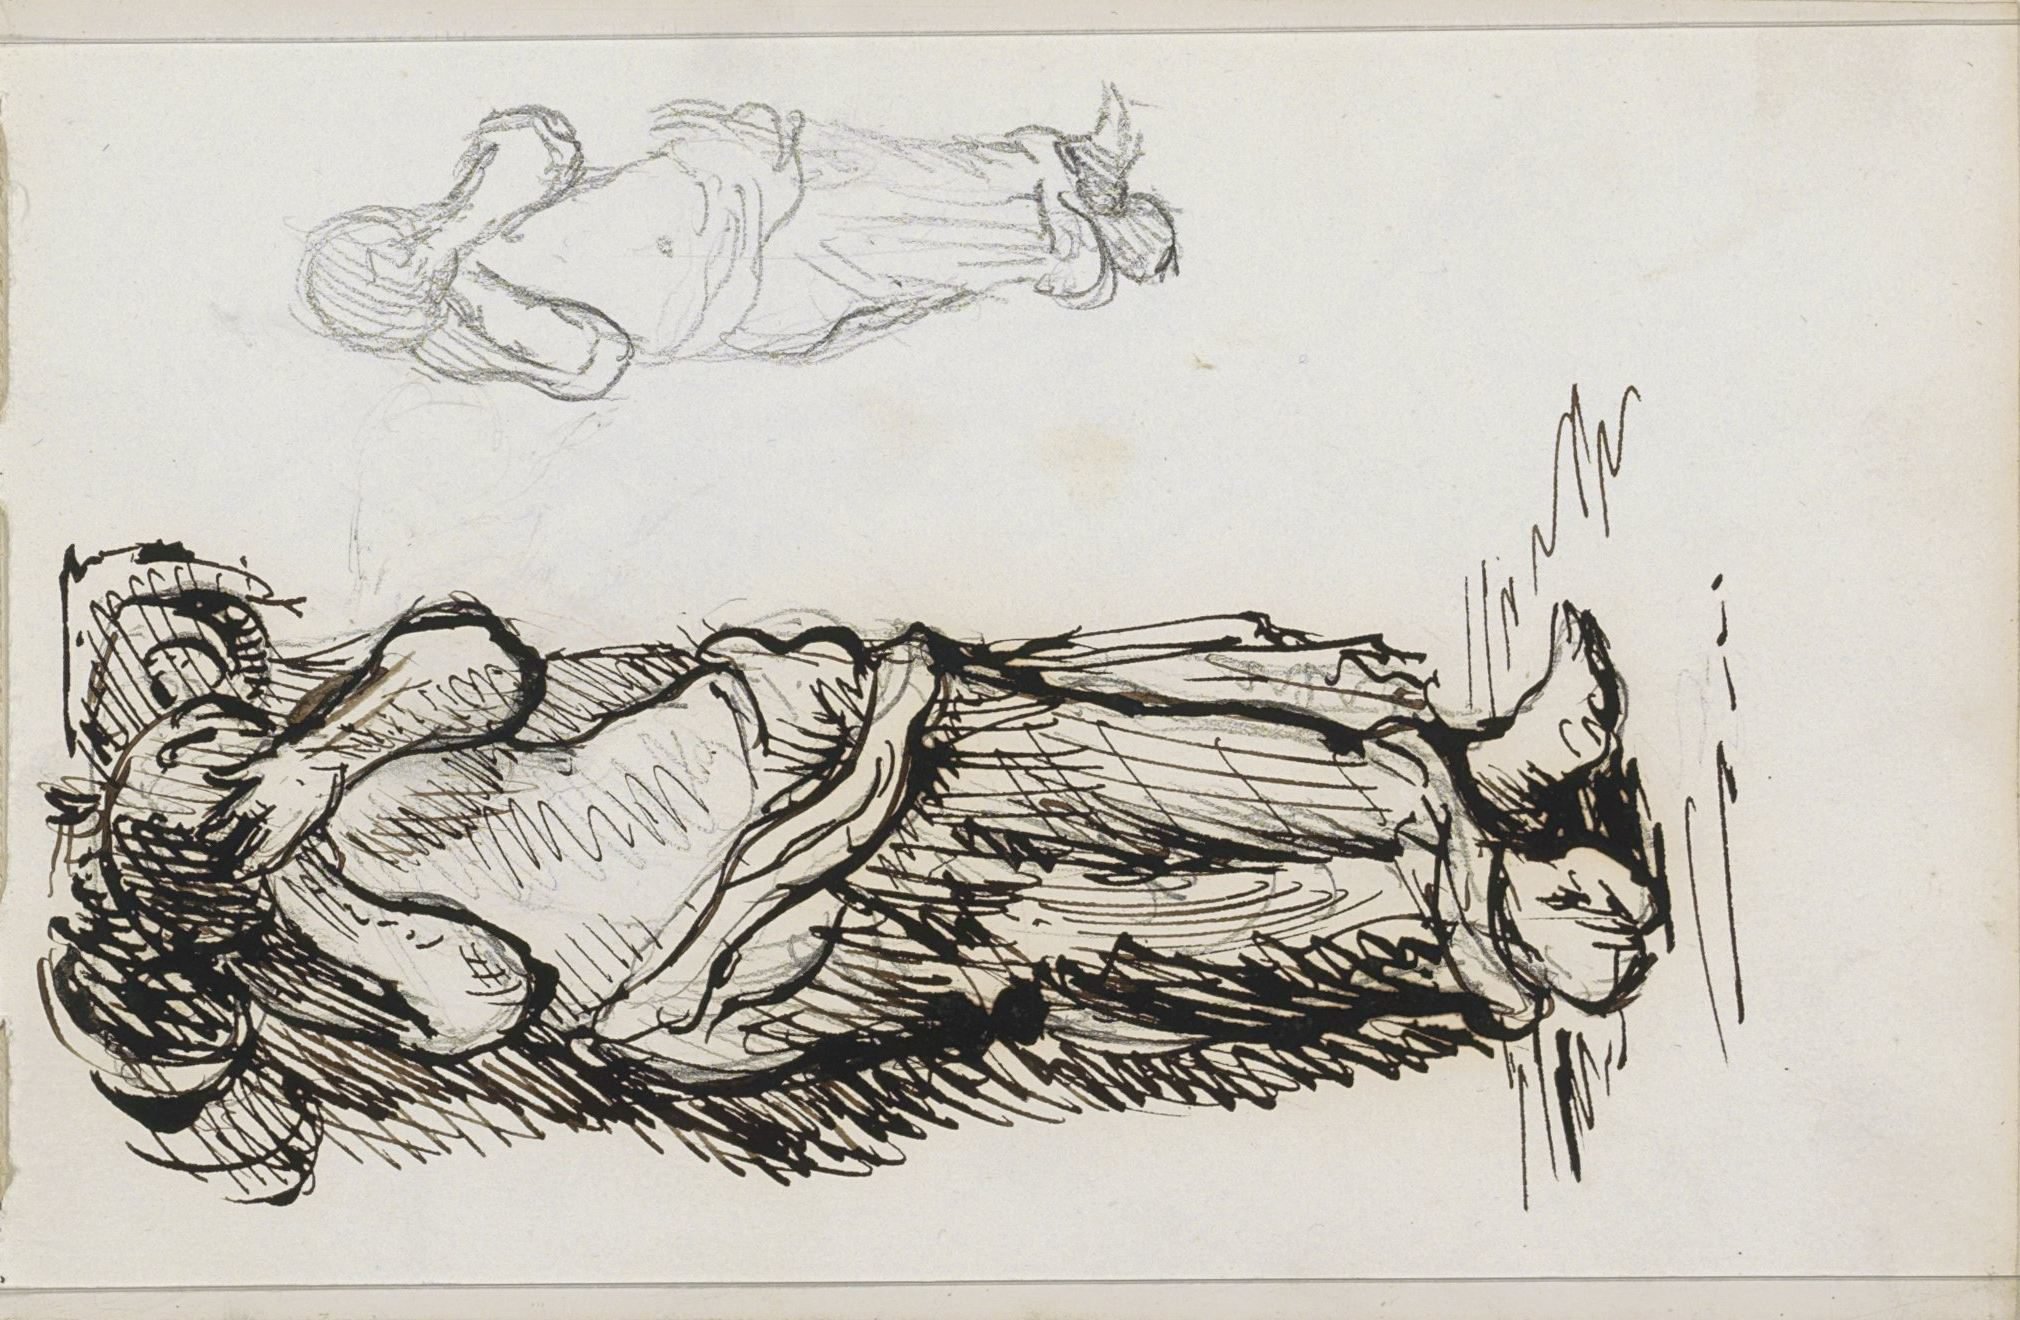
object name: sketchbook leaf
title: Eén van de beelden uit de Vierschaar door Artus Quellinus in het stadhuis van Amsterdam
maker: isaac gosschalk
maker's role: draughtsman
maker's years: 1838-1907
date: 1860-1861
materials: ink, paper, pencil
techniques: pen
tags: carrying something, standing figure - aa - female human figure (+ nude human being)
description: Staande vrouw met ontbloot bovenlijf die een bol optilt. De vrouw draagt een doek om haar middel. Blad 2 recto uit een schetsboek met 29 bladen.